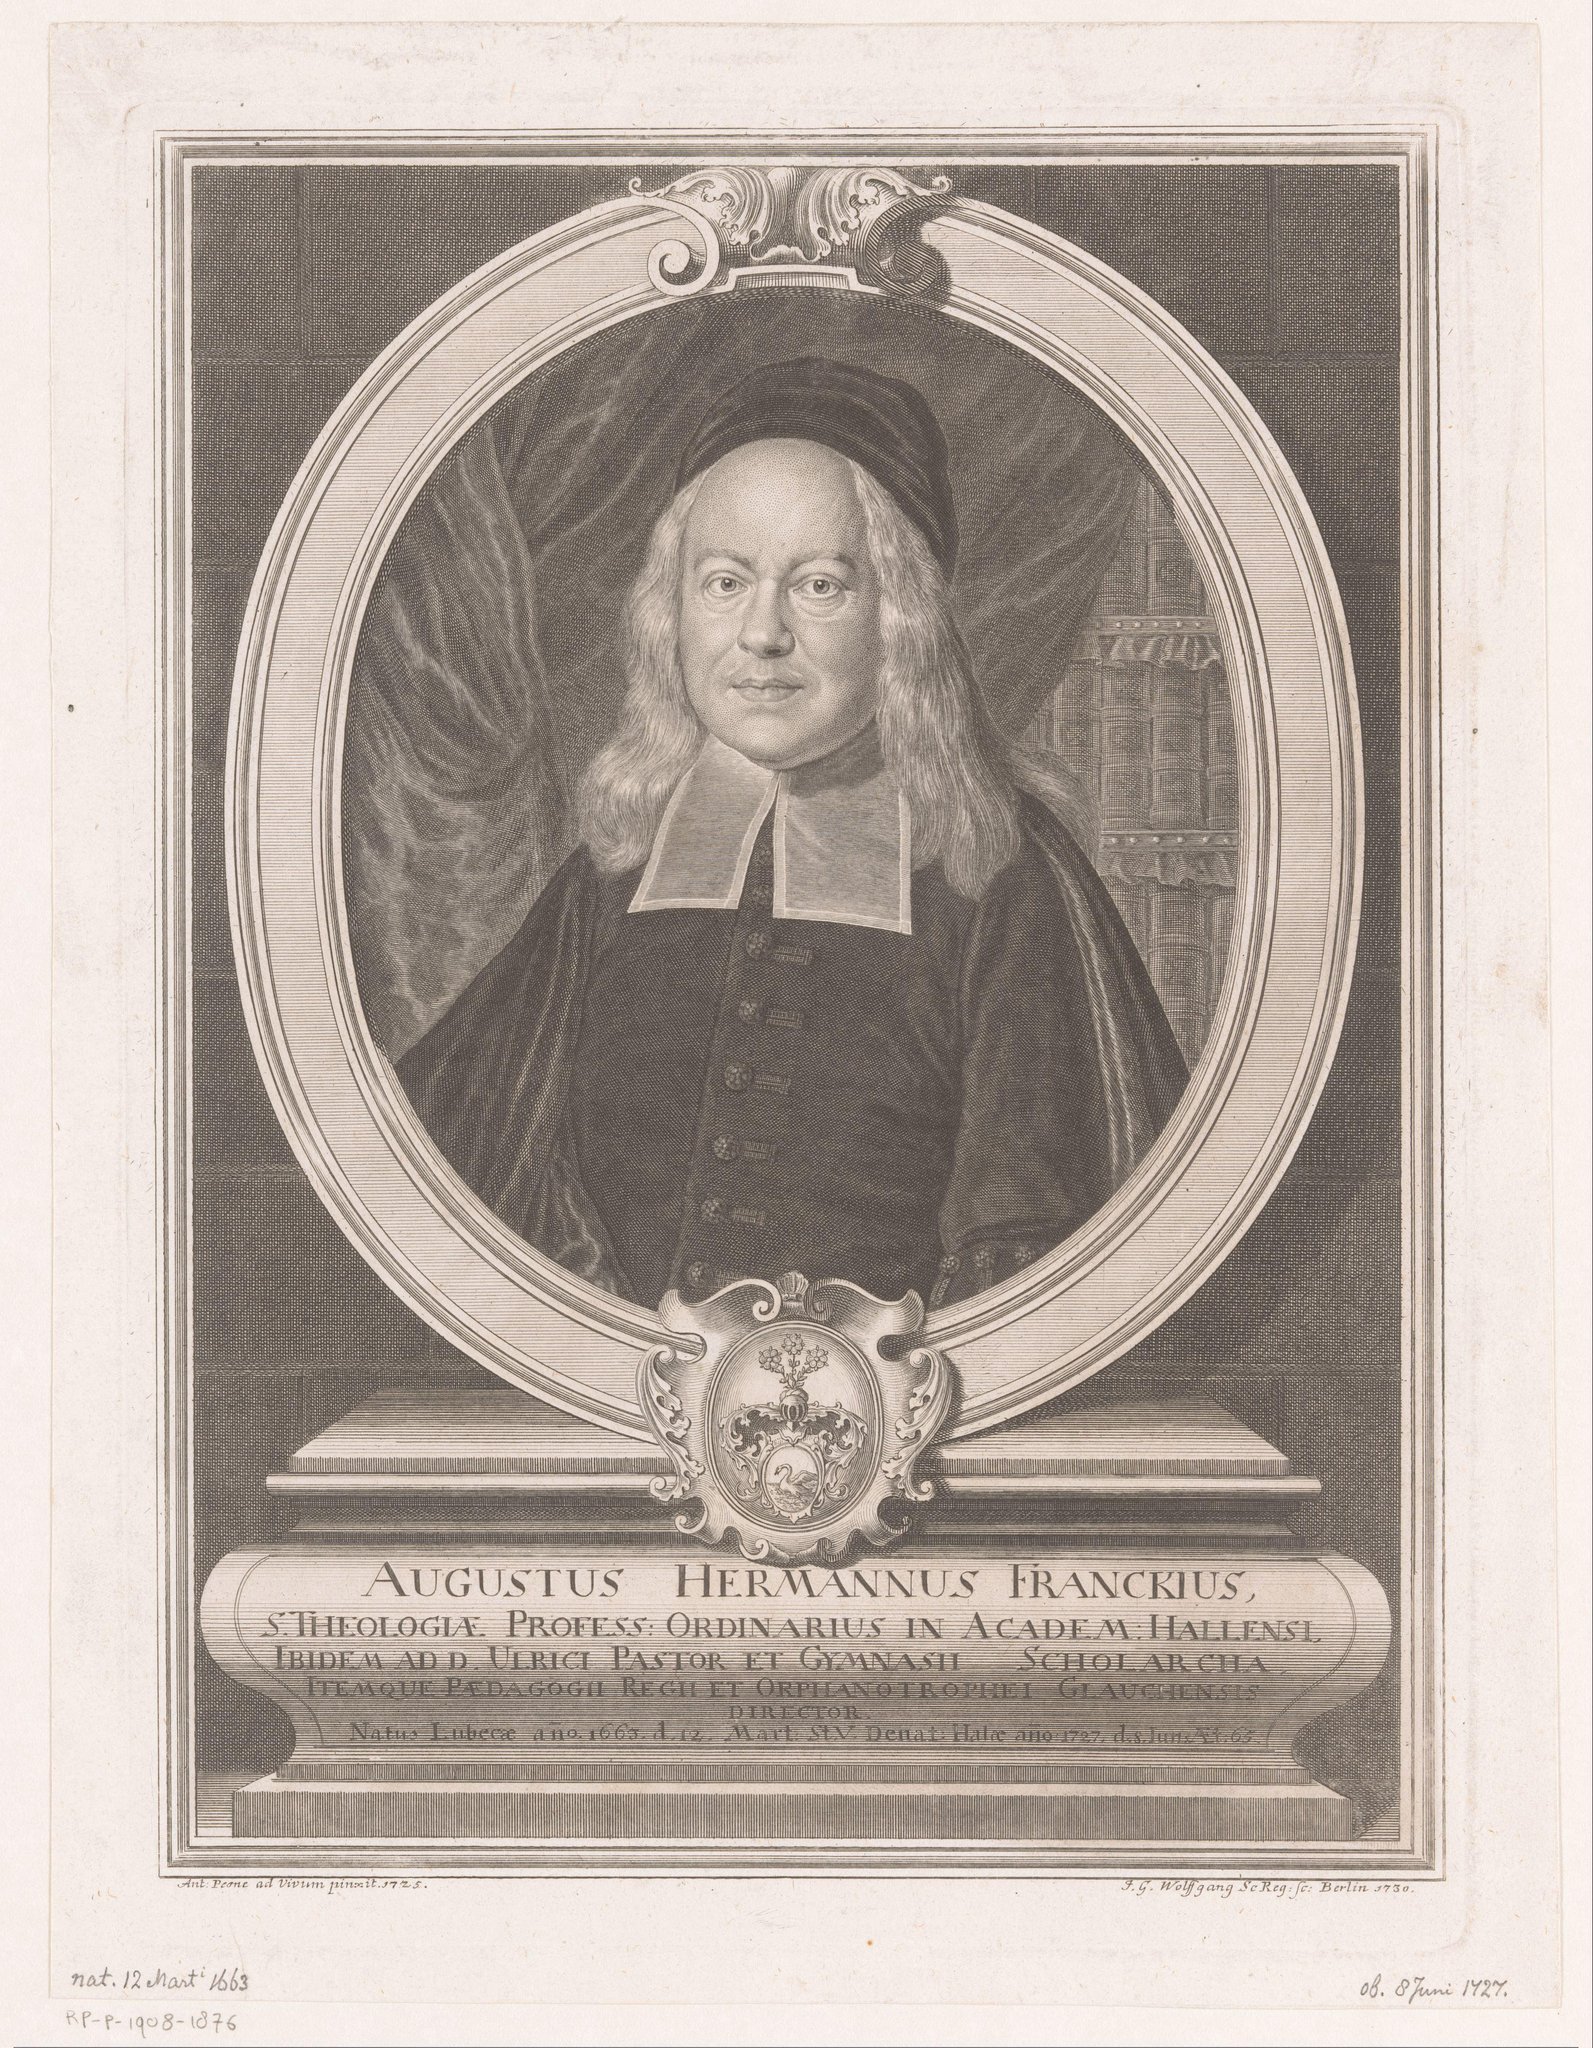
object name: print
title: Portret van August Hermann Francke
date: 1730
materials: paper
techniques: engraving, etching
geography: berlin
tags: bookshelves, historical persons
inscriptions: collector's mark: Lugt 2228